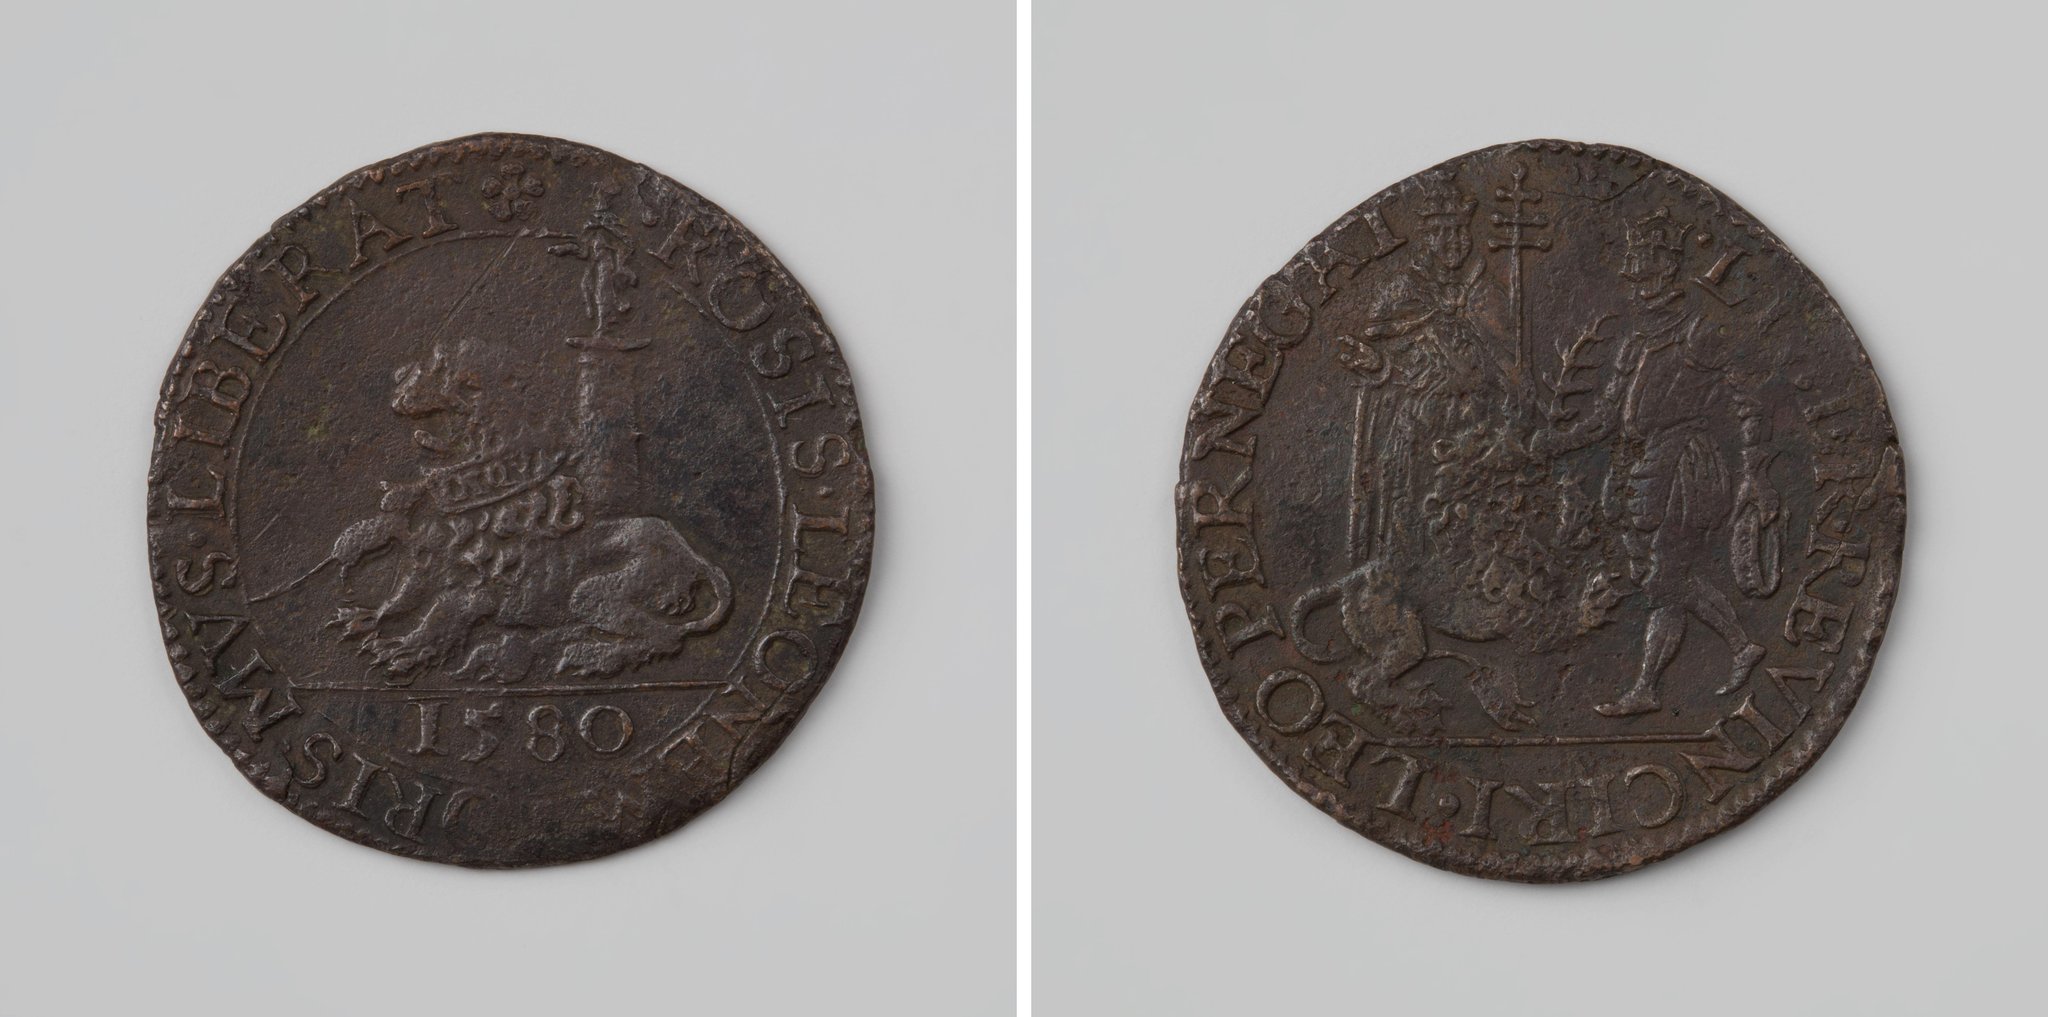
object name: jeton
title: Mislukte vredesonderhandelingen te Keulen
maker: gerard van bylaer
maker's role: die cutter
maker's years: 1540-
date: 1579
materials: copper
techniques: striking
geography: dordrecht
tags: philip ii of spain, rome, gregorius xiii, cologne